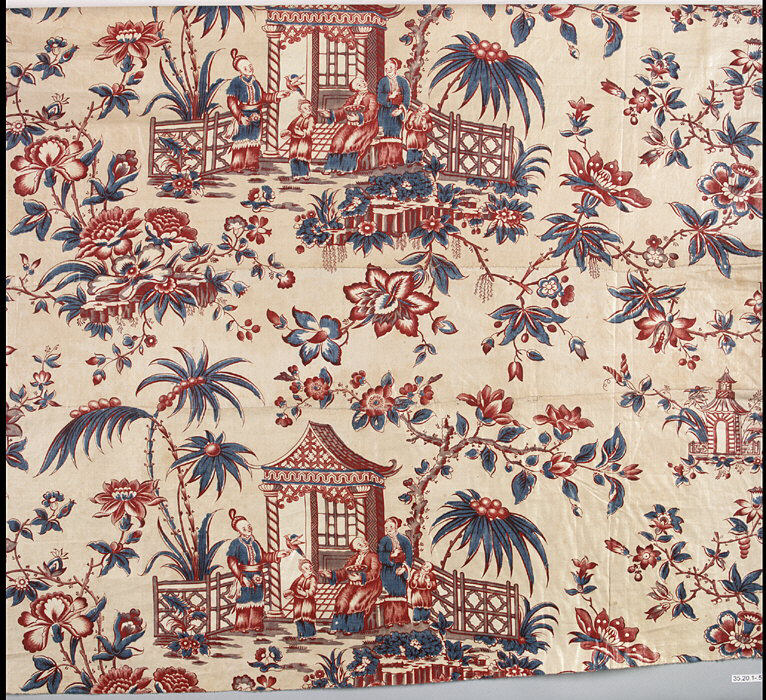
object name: fragment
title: Fragments (5)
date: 1801-1900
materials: cotton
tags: human figures,birds,flowers,leaves